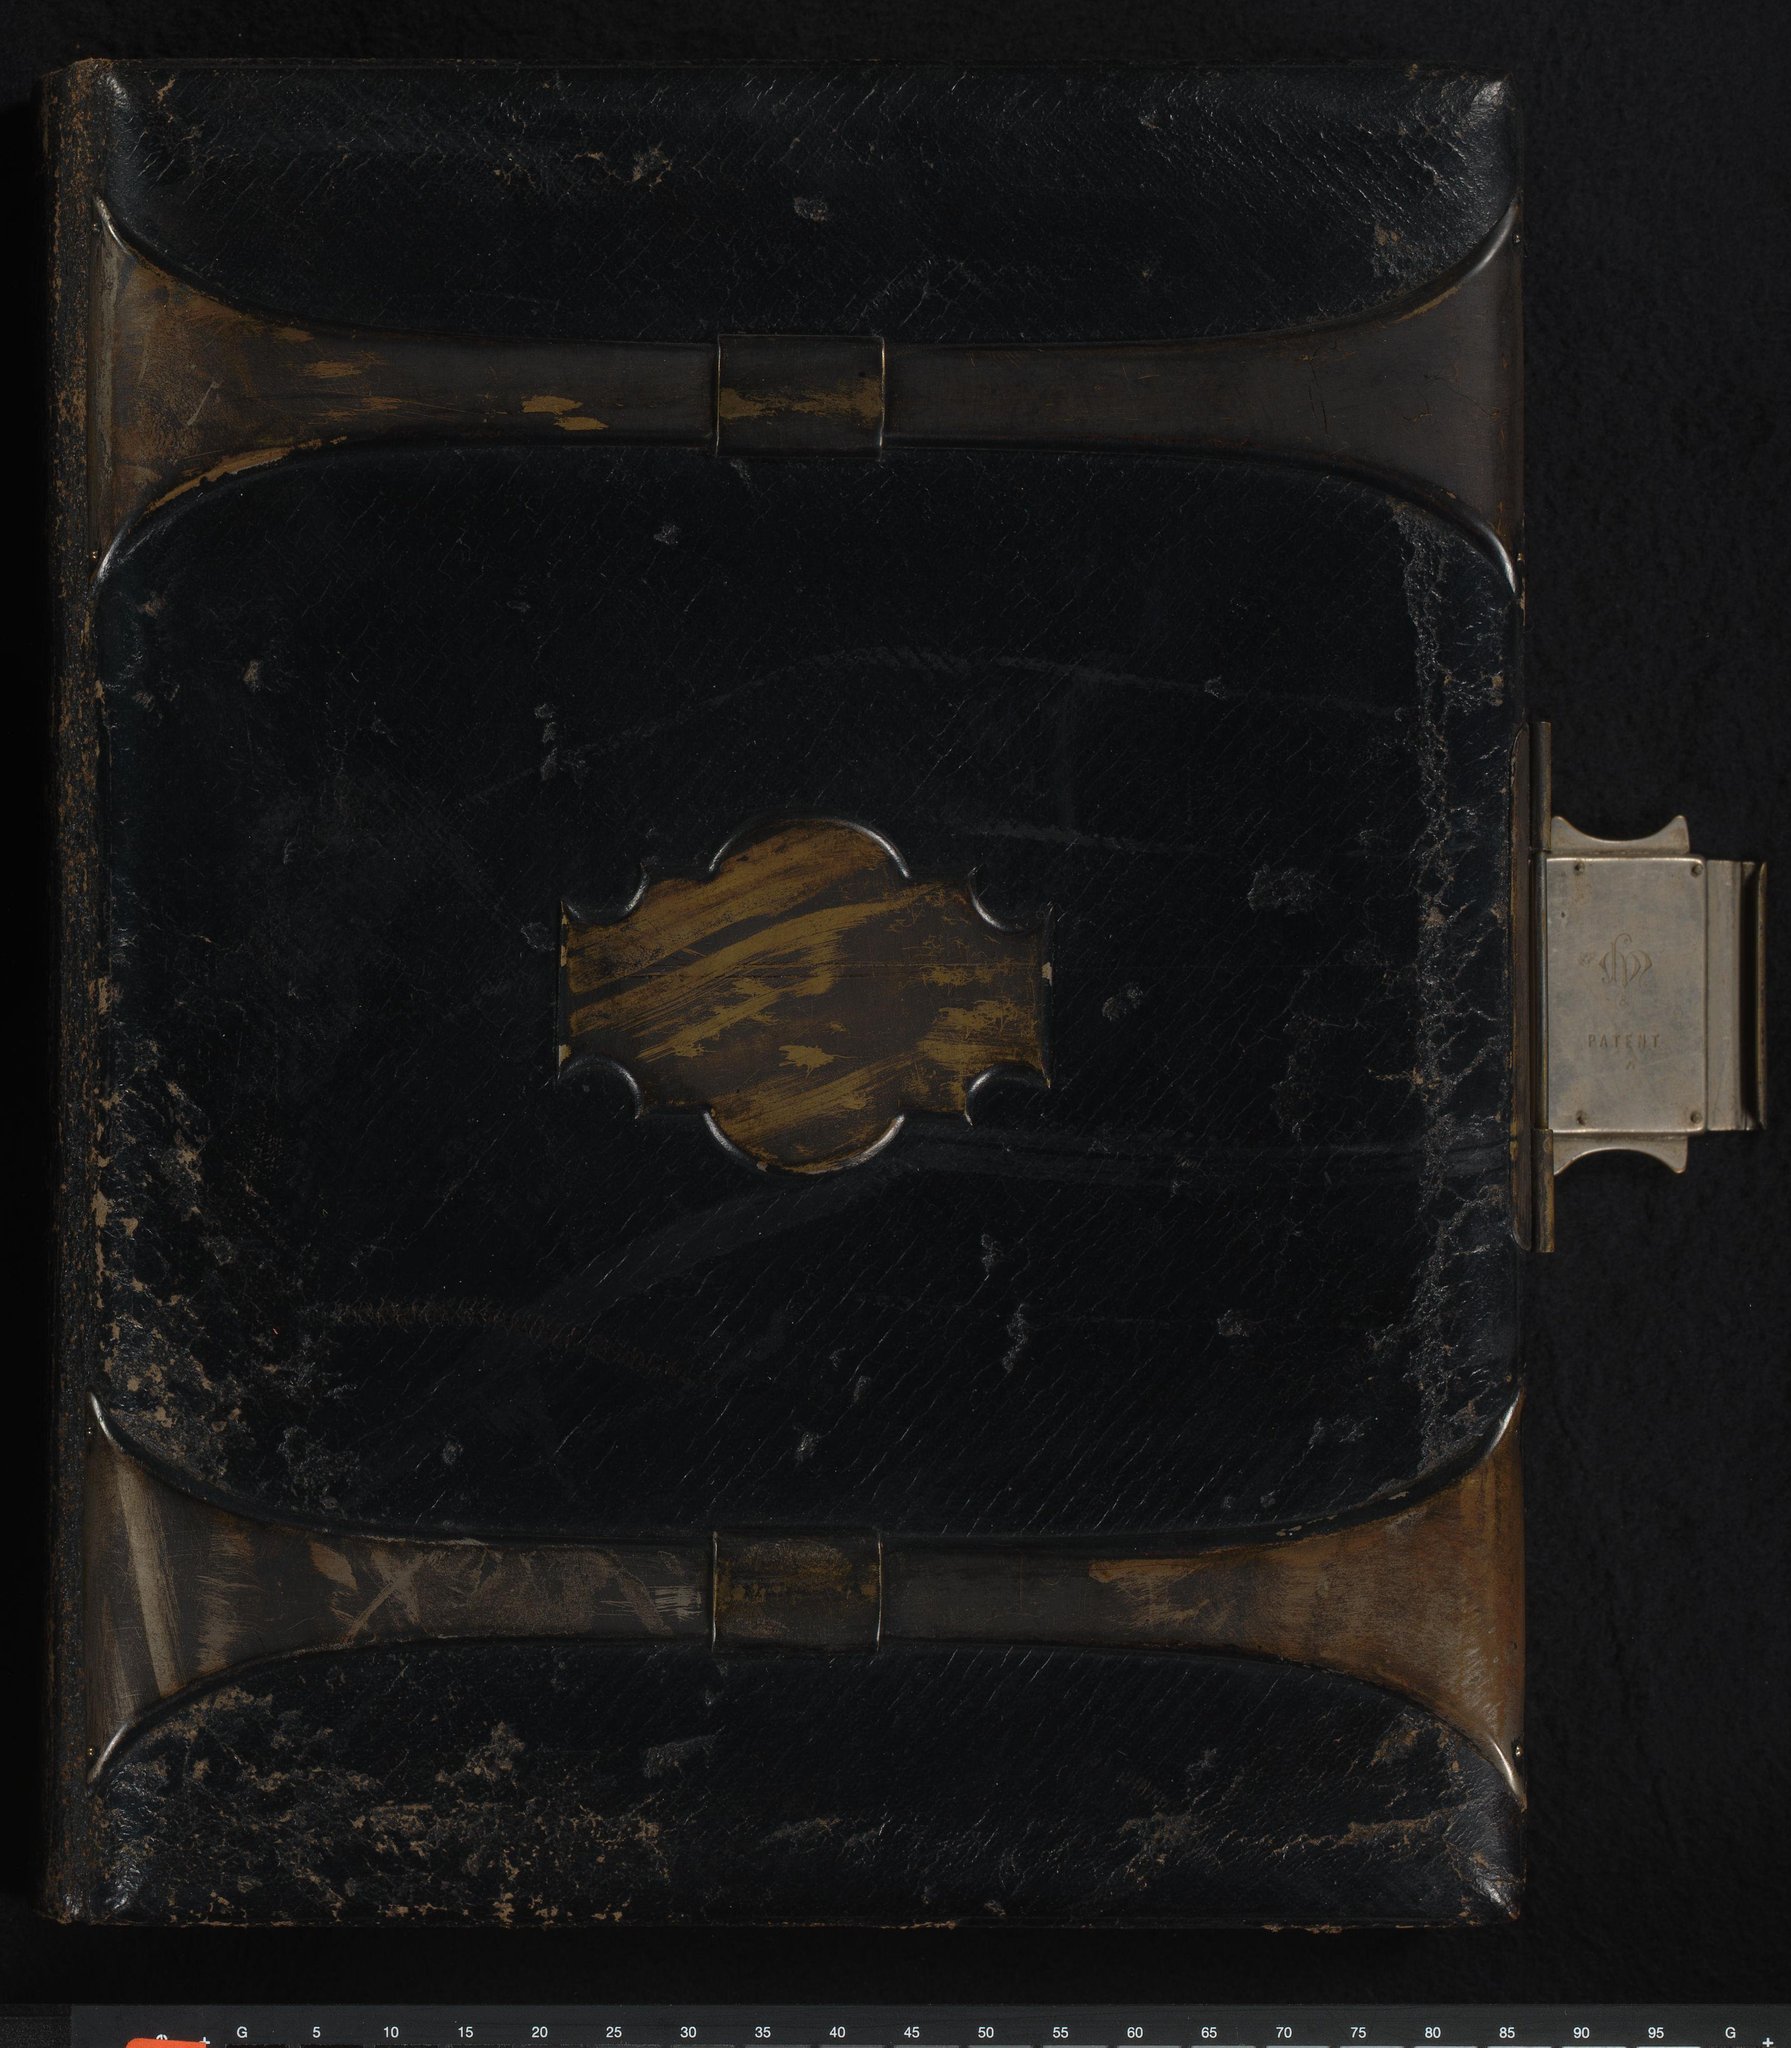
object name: photograph album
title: Belgisch familiealbum met 130 foto's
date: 1860-1900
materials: cardboard, leather, metal, paper, photographic support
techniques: albumen print, carbon print, ferrotyping, salted paper print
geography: brussels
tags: historical persons - bb - woman, child, historical persons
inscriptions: collector's mark: ‘DIENST/ VERSPREIDE/ RIJKSKOLLEKTIES/ (...) A 814’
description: Fotoalbum met in totaal 130 foto's op 44 pagina's. Iedere pagina bevat een passe-partout voor een kabinetfoto of 4 passe-partouts voor cartes-de-visite. Het album bevat 12 kabinetfoto's, 116 cartes-de-visite, 1 niet opgeplakte foto in een passe-partout voor een carte-de-visite en achterin het album een losse foto van afwijkend formaat. Niet alle passe-partouts in het album zijn gevuld. Afgebeeld zijn portretten van onbekende mannen, vrouwen en kinderen, vermoedelijk uit één familie. Bij enkele cartes-de-visite is op verso een naam vermeld, vermoedelijk van de geportretteerde. Ook bevat het album een bidprent voor de overleden Adèle Sohet-Cardron. De foto's zijn gemaakt door Belgische en Franse fotografen, waaronder Eugène Guérin (30), Géruzet frères en Albert Delabarre. Van 19 foto's is de fotograaf anoniem.